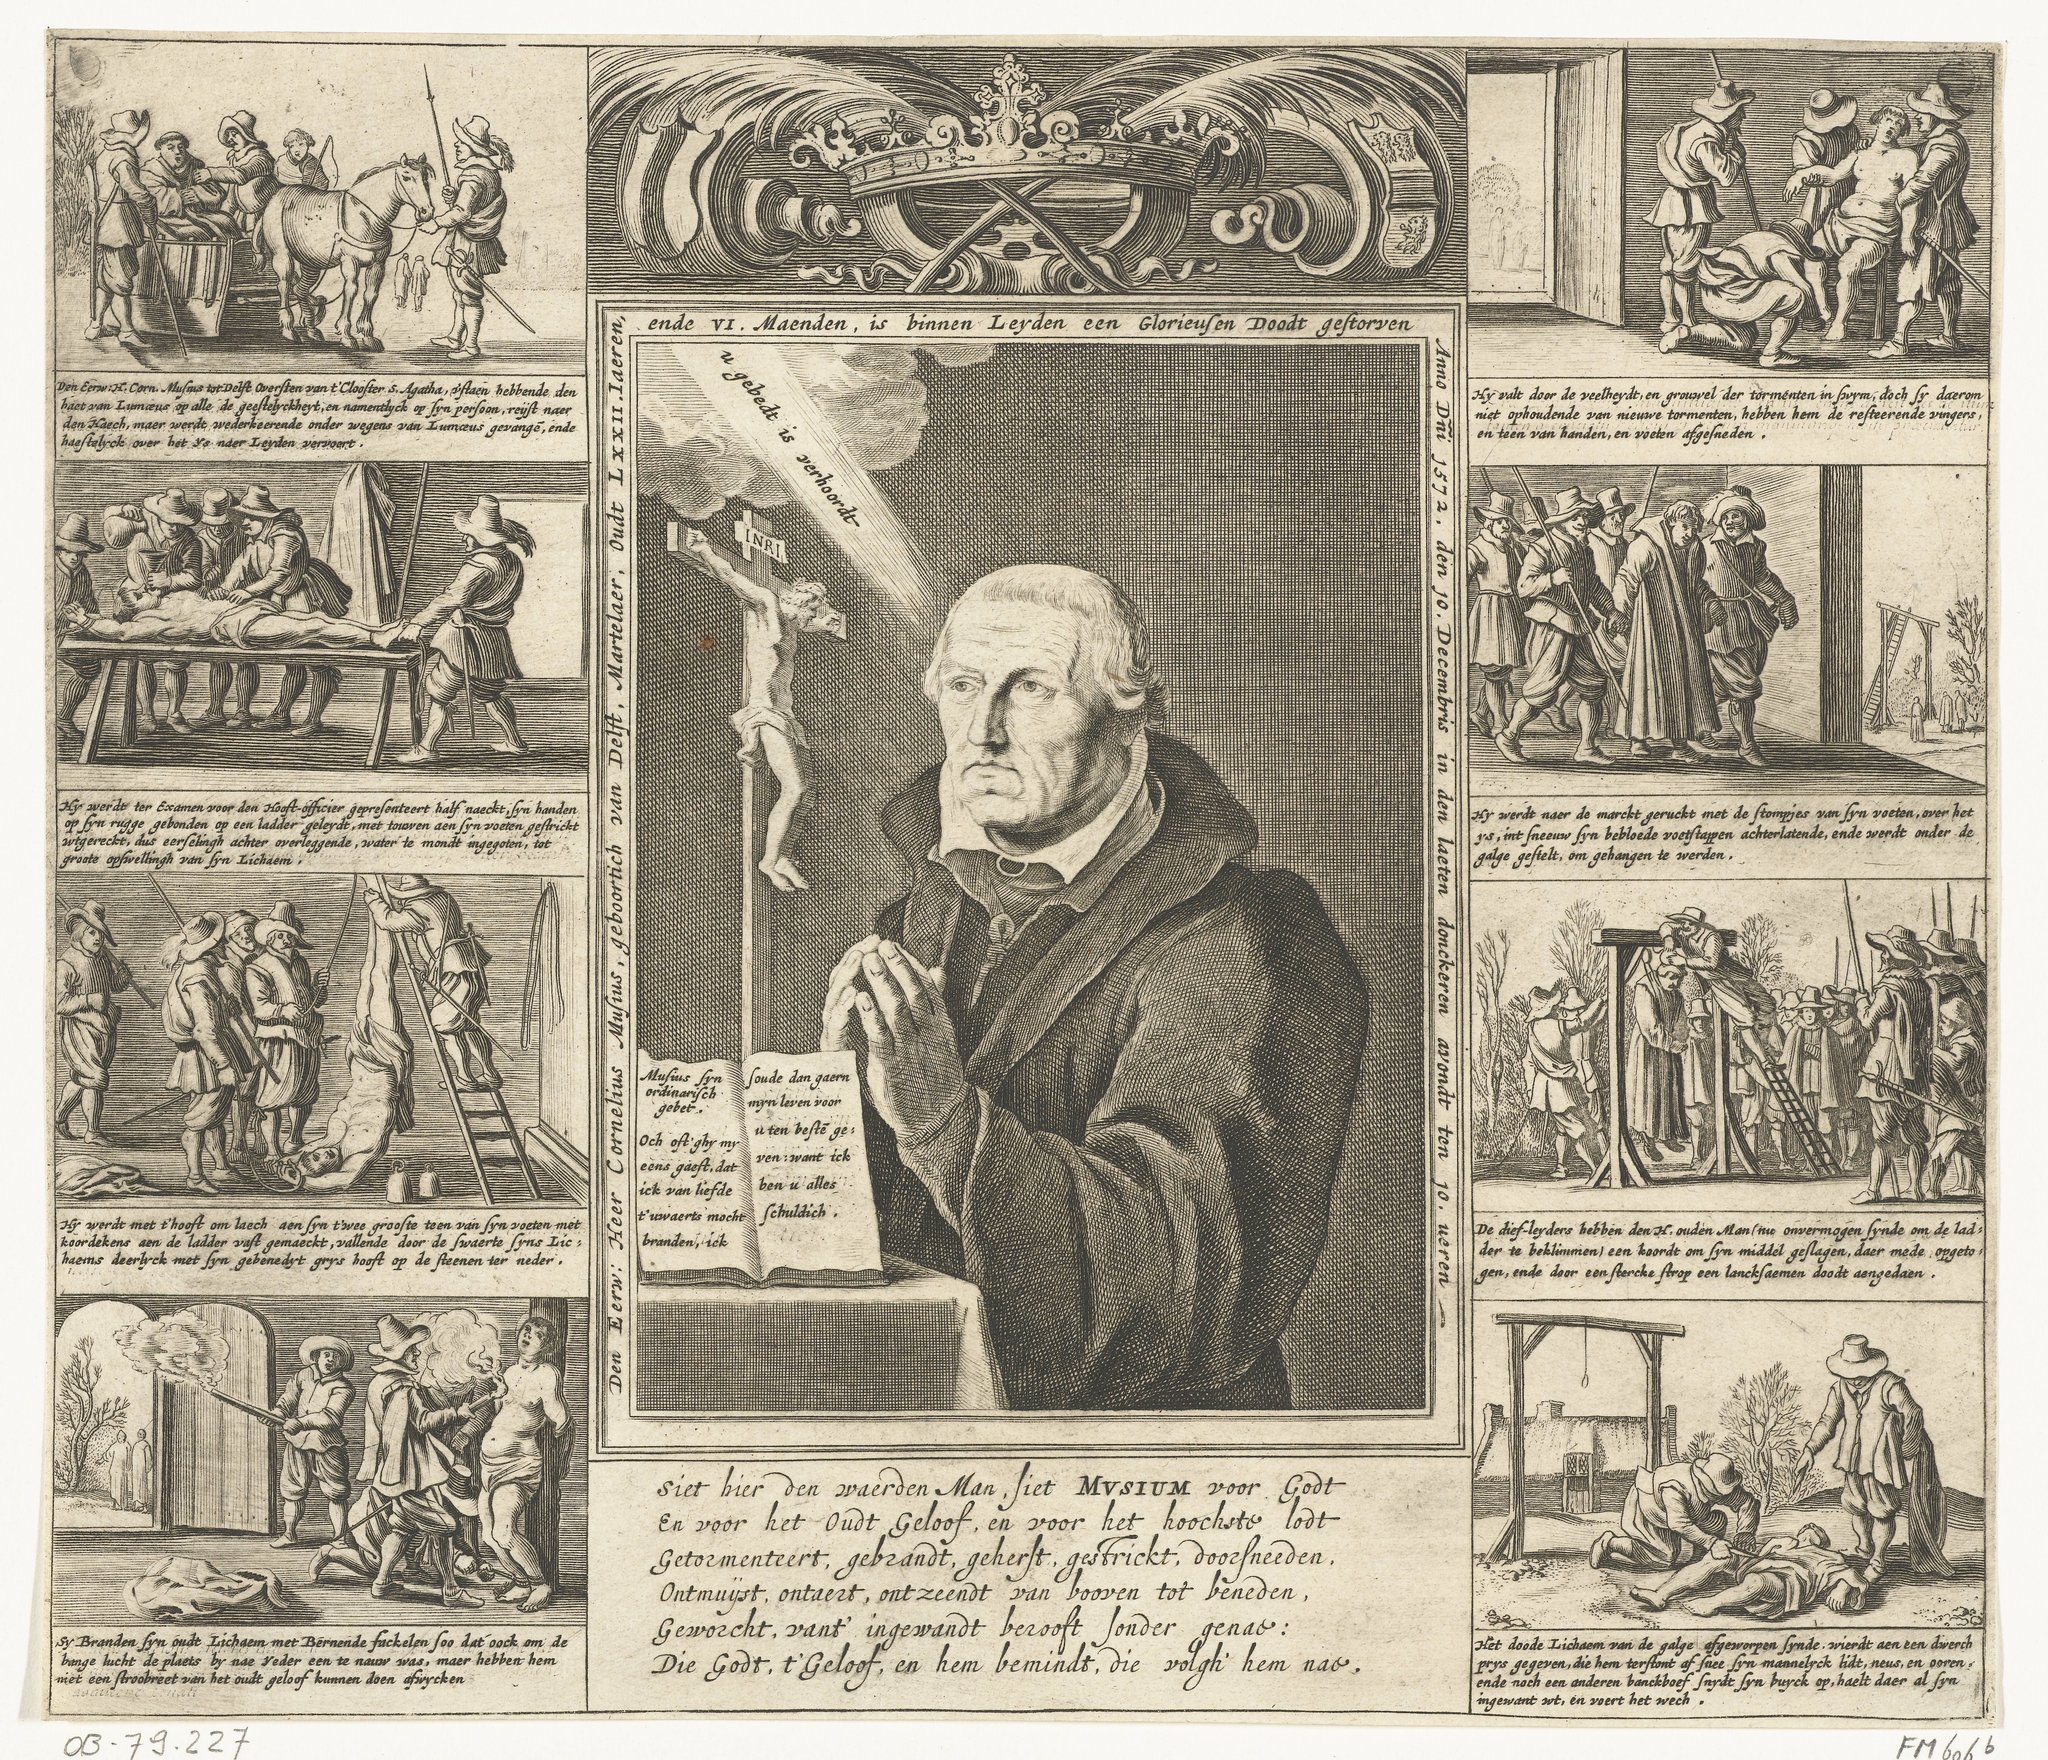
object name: history print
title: Portret van Cornelis Musius, omringd door taferelen uit zijn martelaarschap, 1572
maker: jan van de velde (ii)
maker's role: draughtsman, painter, print maker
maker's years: 1593-1641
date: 1632-1634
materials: paper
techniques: engraving, etching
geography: northern netherlands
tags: delft, leiden, priest, cornelis musius, violent death by hanging, mutilation of the corpse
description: Portret van Cornelis Musius met gevouwen bij een kruisbeeld, omringd door acht taferelen uit zijn martelaarschap aan de hand van geuzen onder Lumey, 10 december 1572. Boven het portret een kroon en palmtakken. Bij de scènes en rond het portret onderschriften in het Nederlands.